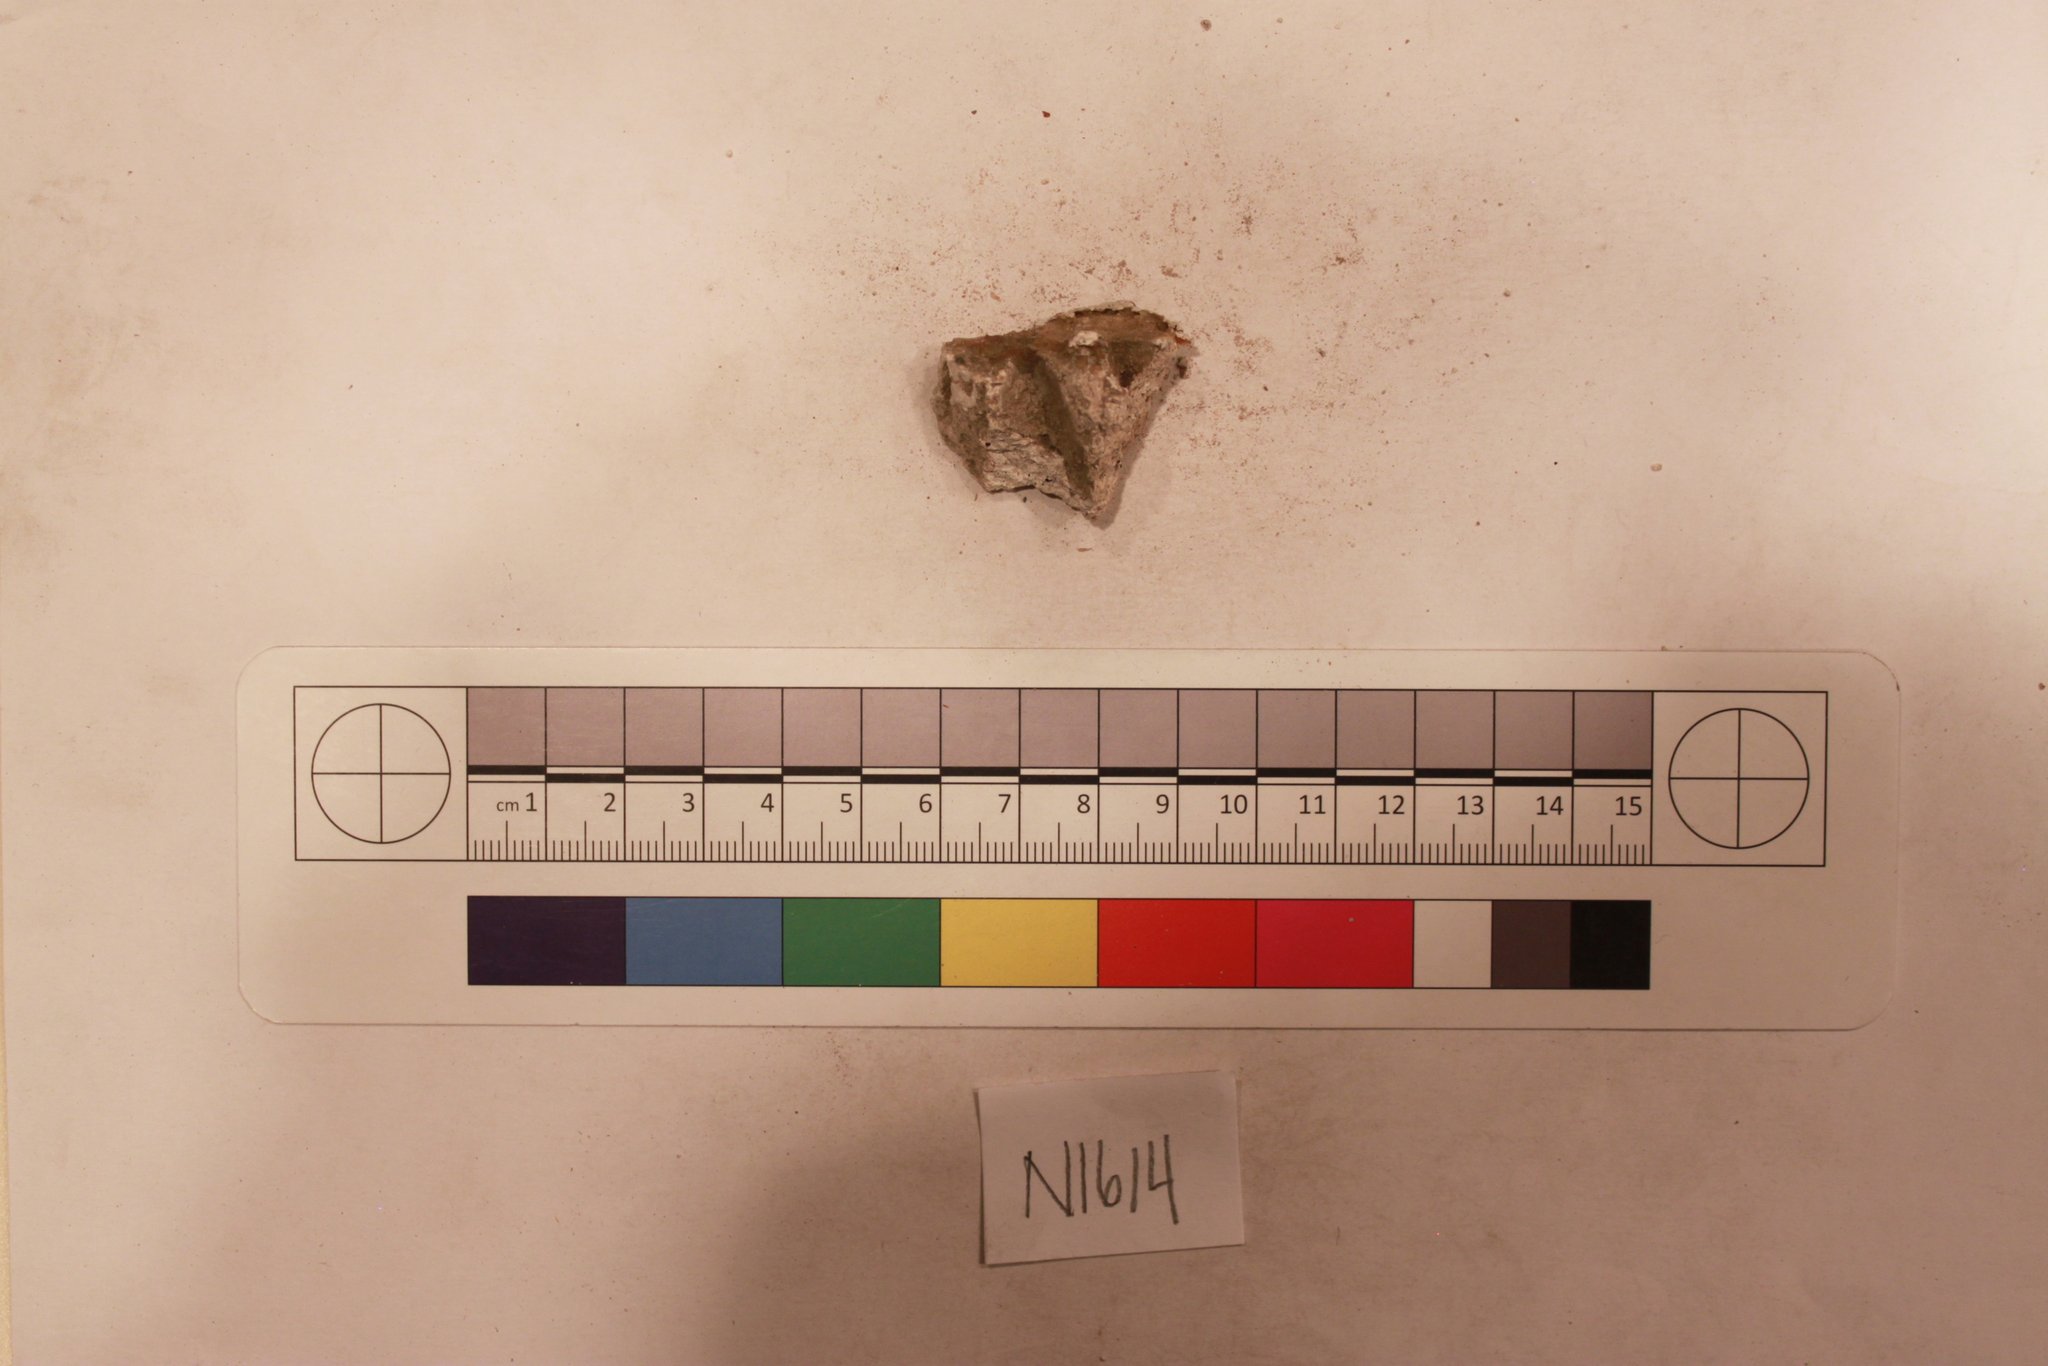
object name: fragment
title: Stucco Fragment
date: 701-1200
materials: plaster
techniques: carving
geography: iran